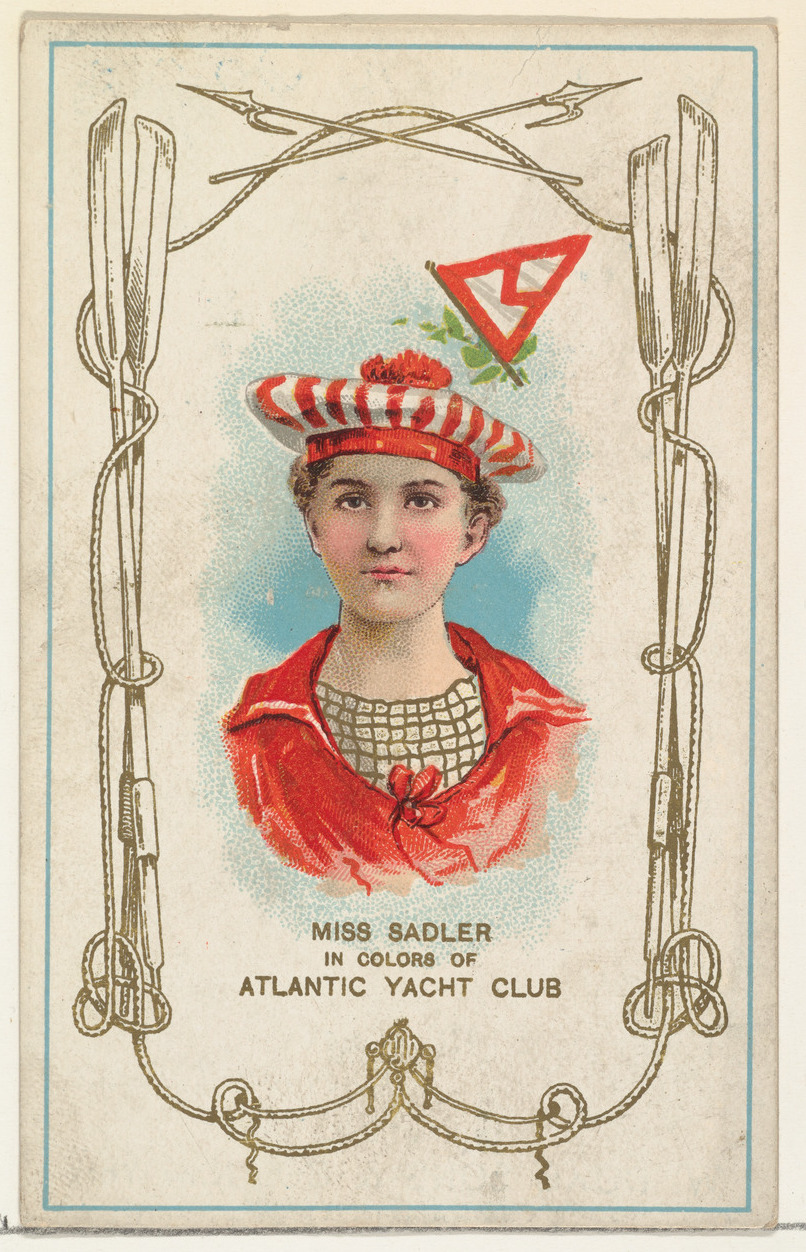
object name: print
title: Miss Sadler in Colors of Atlantic Yacht Club, from the Yacht Colors of the World series (N140) issued by Duke Sons & Co. to promote Honest Long Cut Tobacco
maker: w. duke, sons & co.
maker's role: publisher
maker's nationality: american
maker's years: 1870-1920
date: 1890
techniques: color lithograph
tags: portraits,women,flags